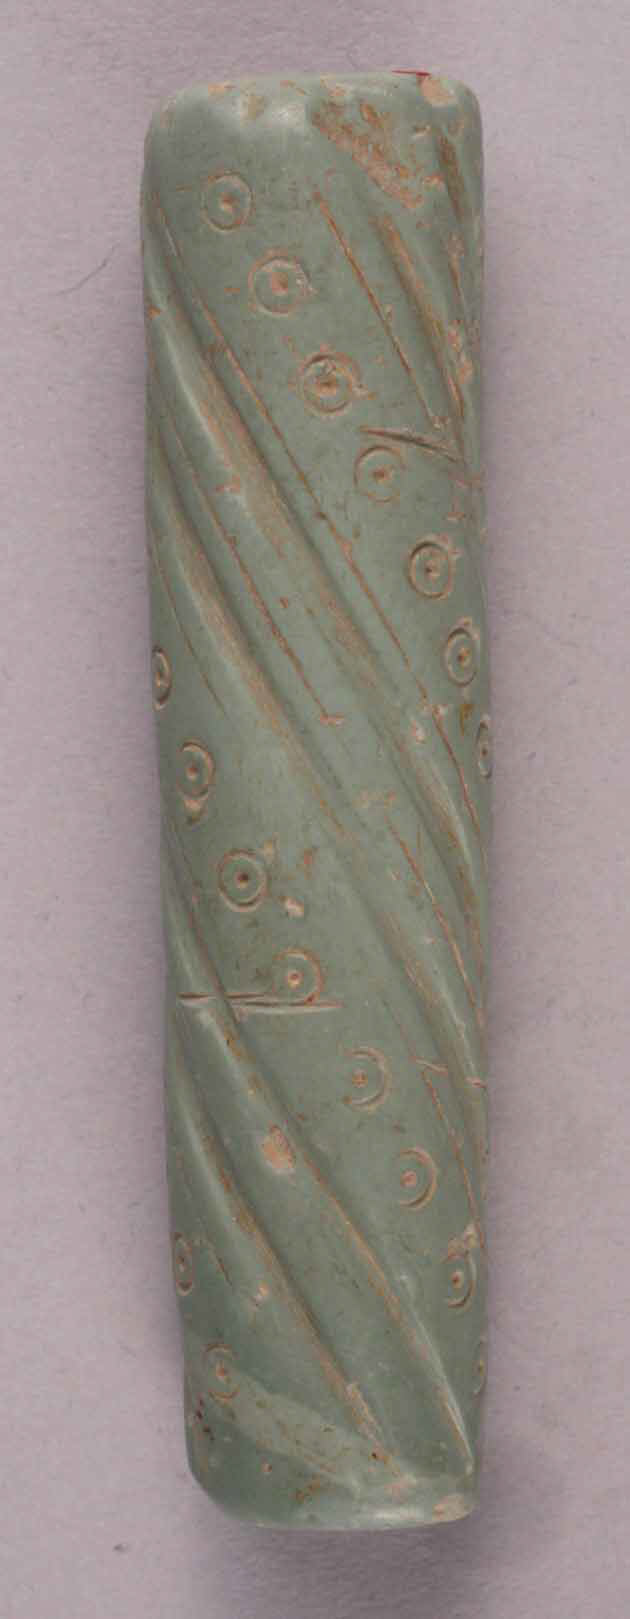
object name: fragment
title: Stone Fragment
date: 801-1000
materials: stone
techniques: carving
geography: iran